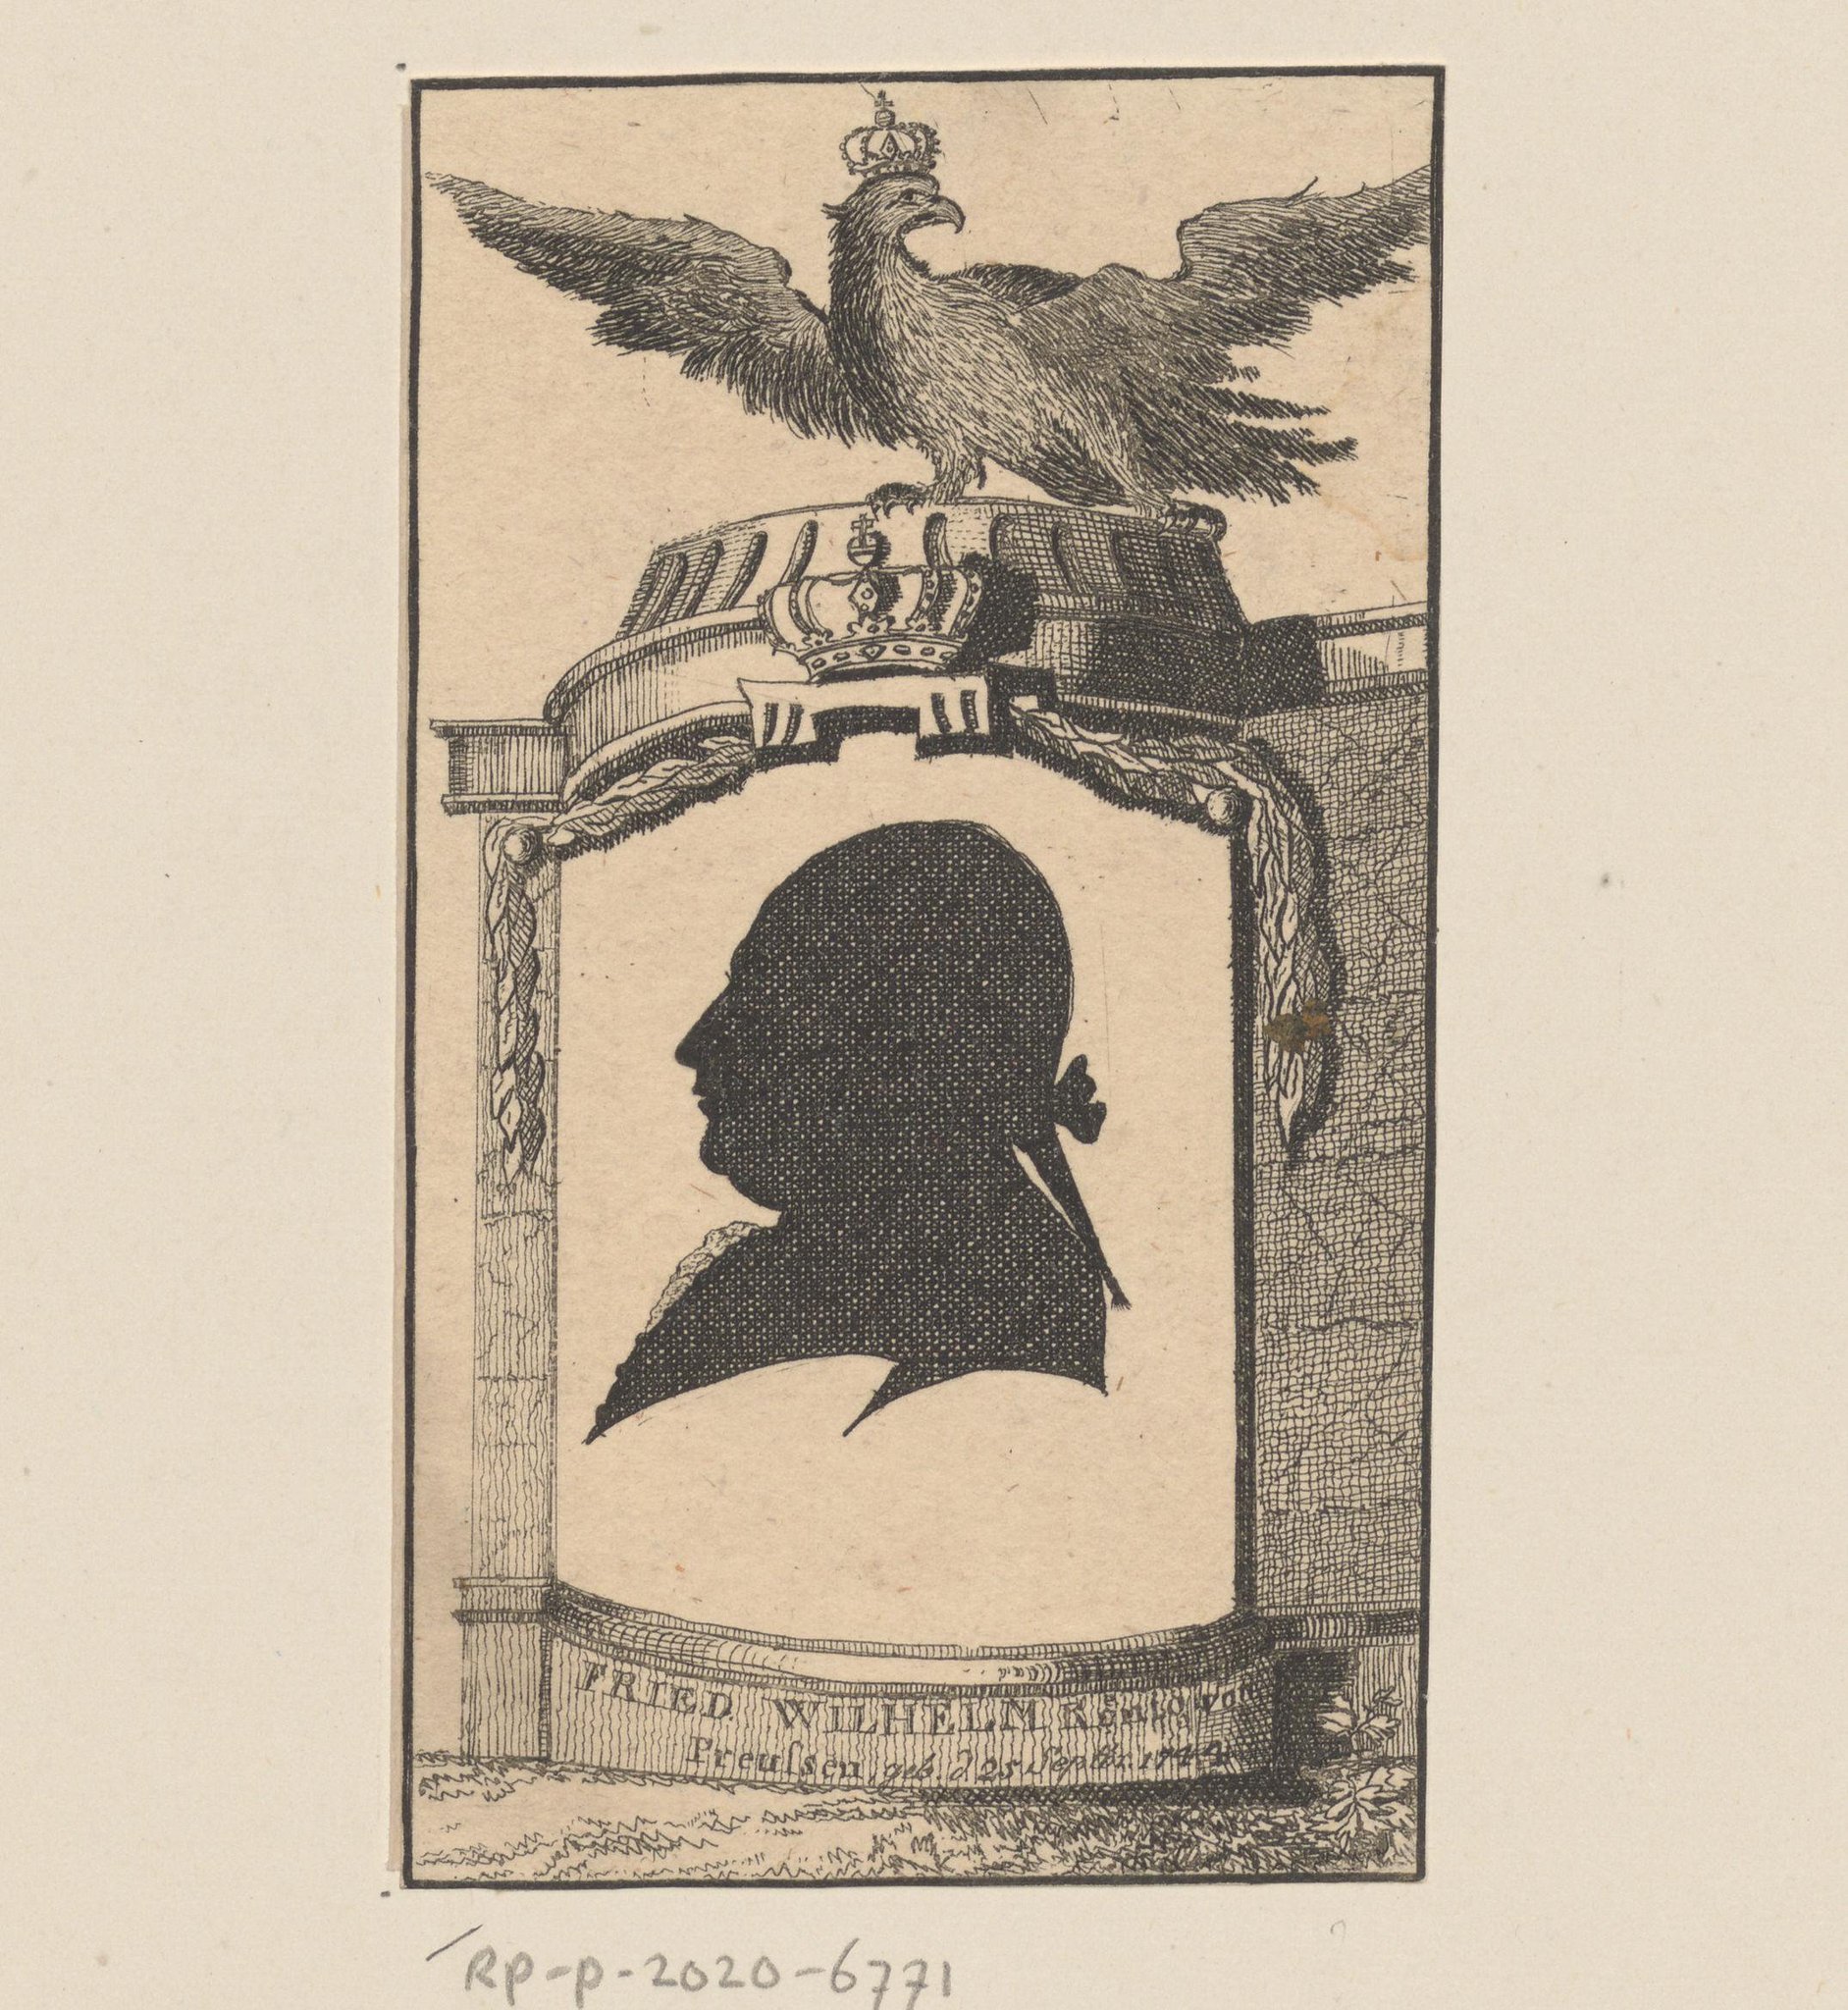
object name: print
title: Silhouetportret van Frederik Willem II van Pruisen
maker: Anonymous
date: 1786-1797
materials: paper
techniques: etching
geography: germany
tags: berlin, frederik willem ii (koning van pruisen), crown (symbol of sovereignty), predatory birds: eagle, historical persons, king